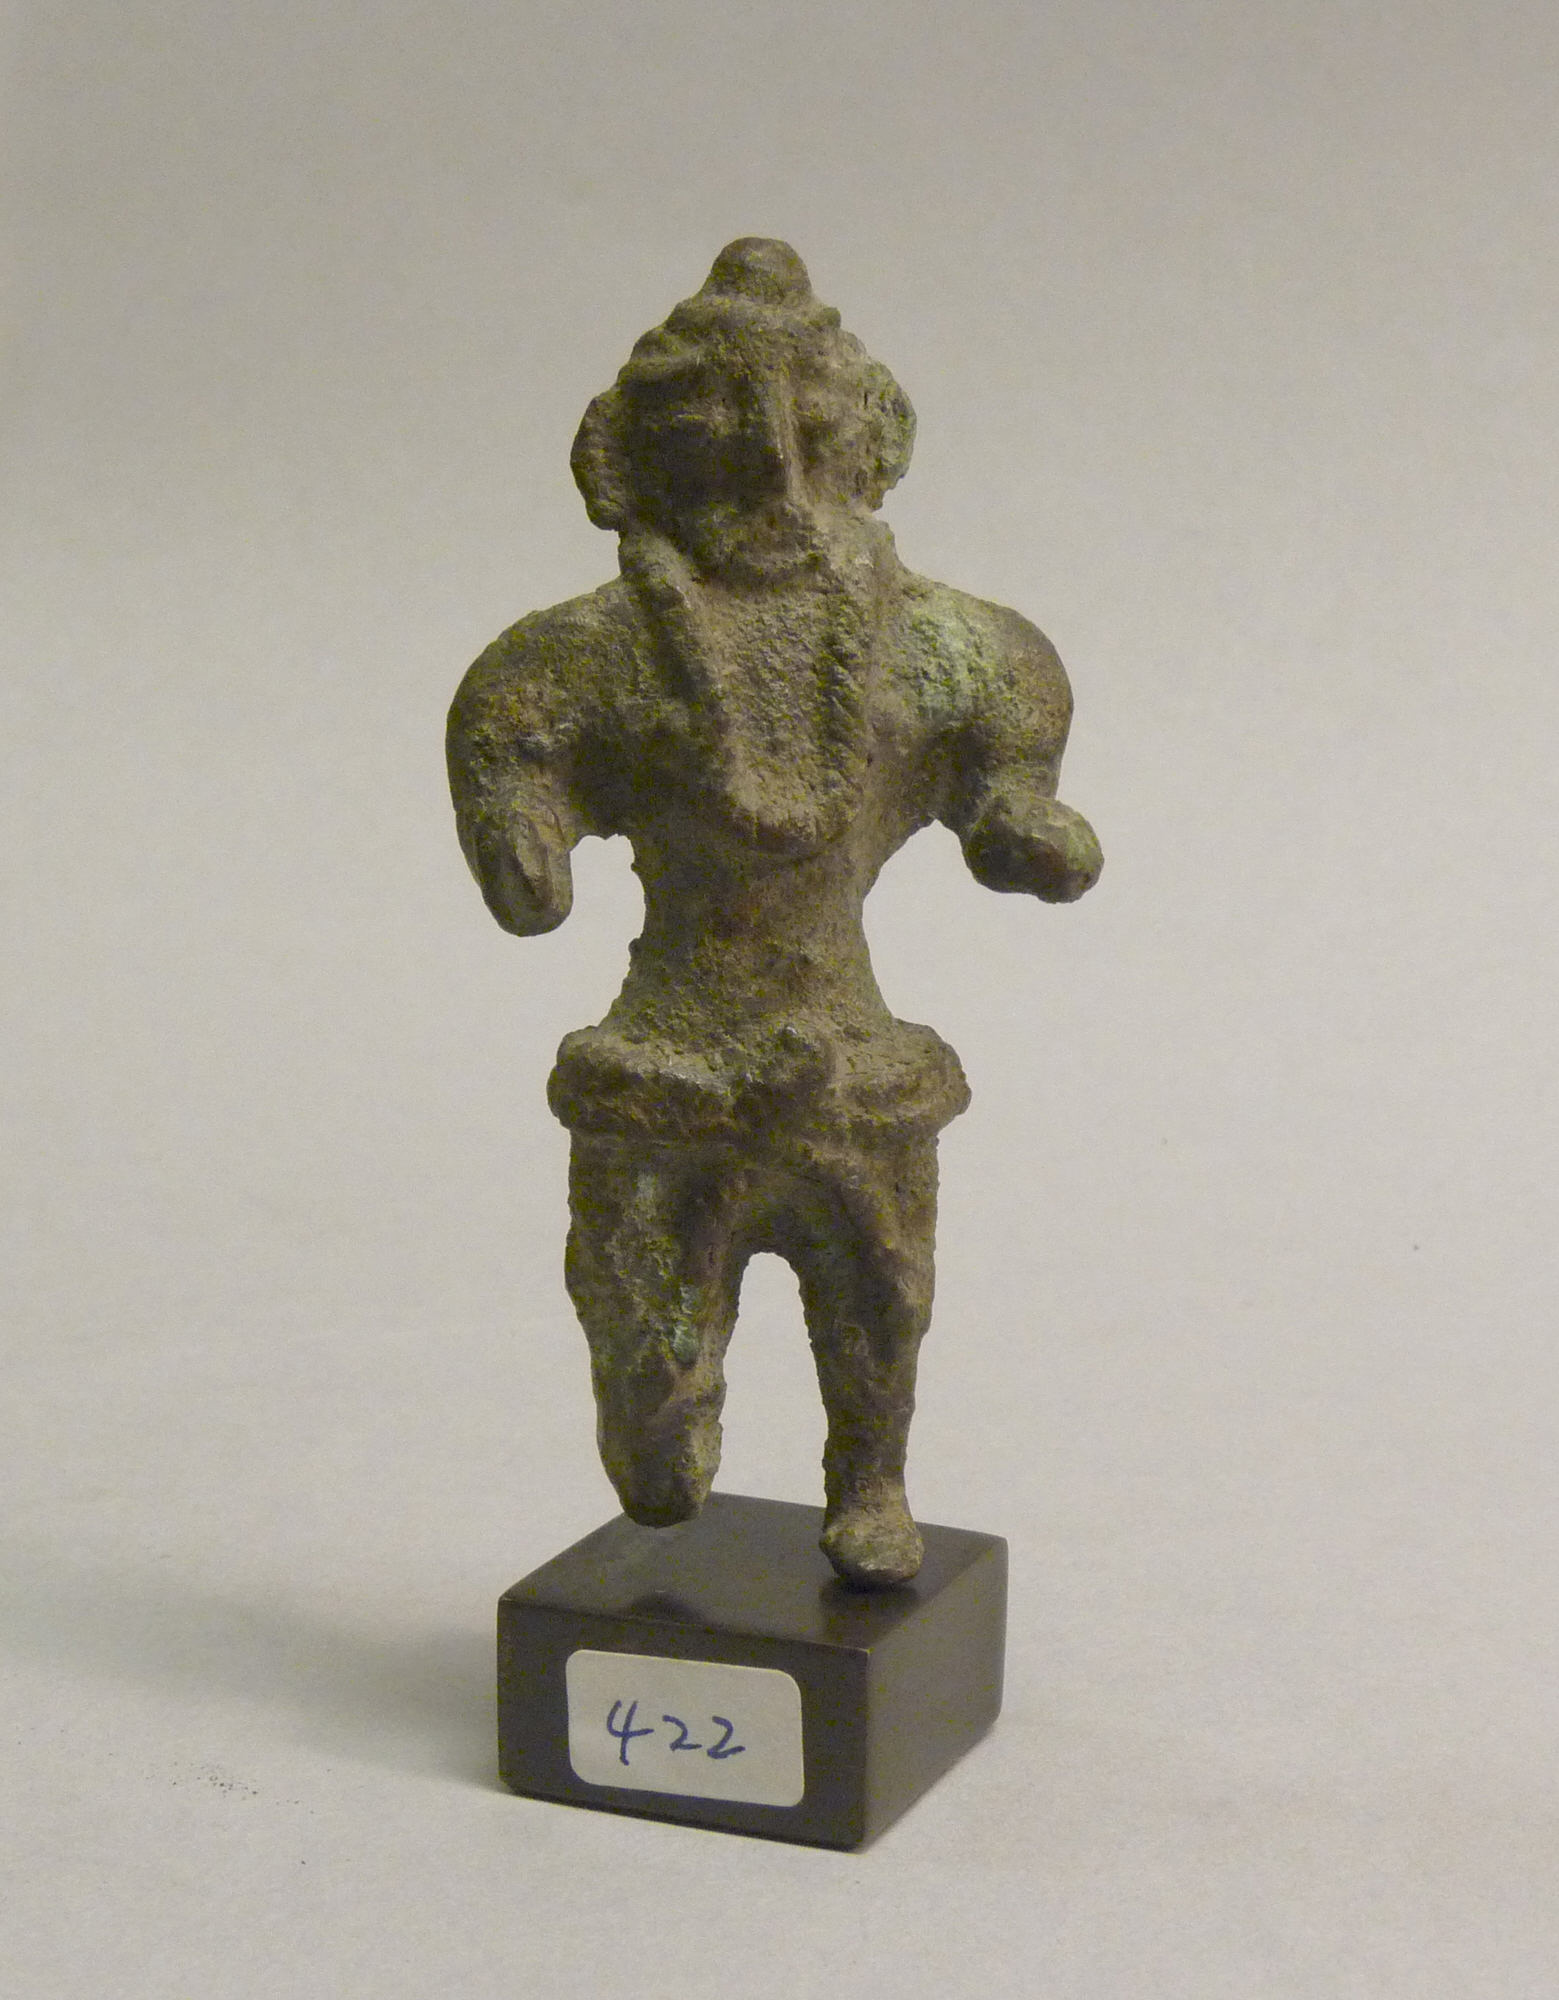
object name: figure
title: Standing Figure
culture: indonesian, javanese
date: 500 BCE-300 CE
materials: bronze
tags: men